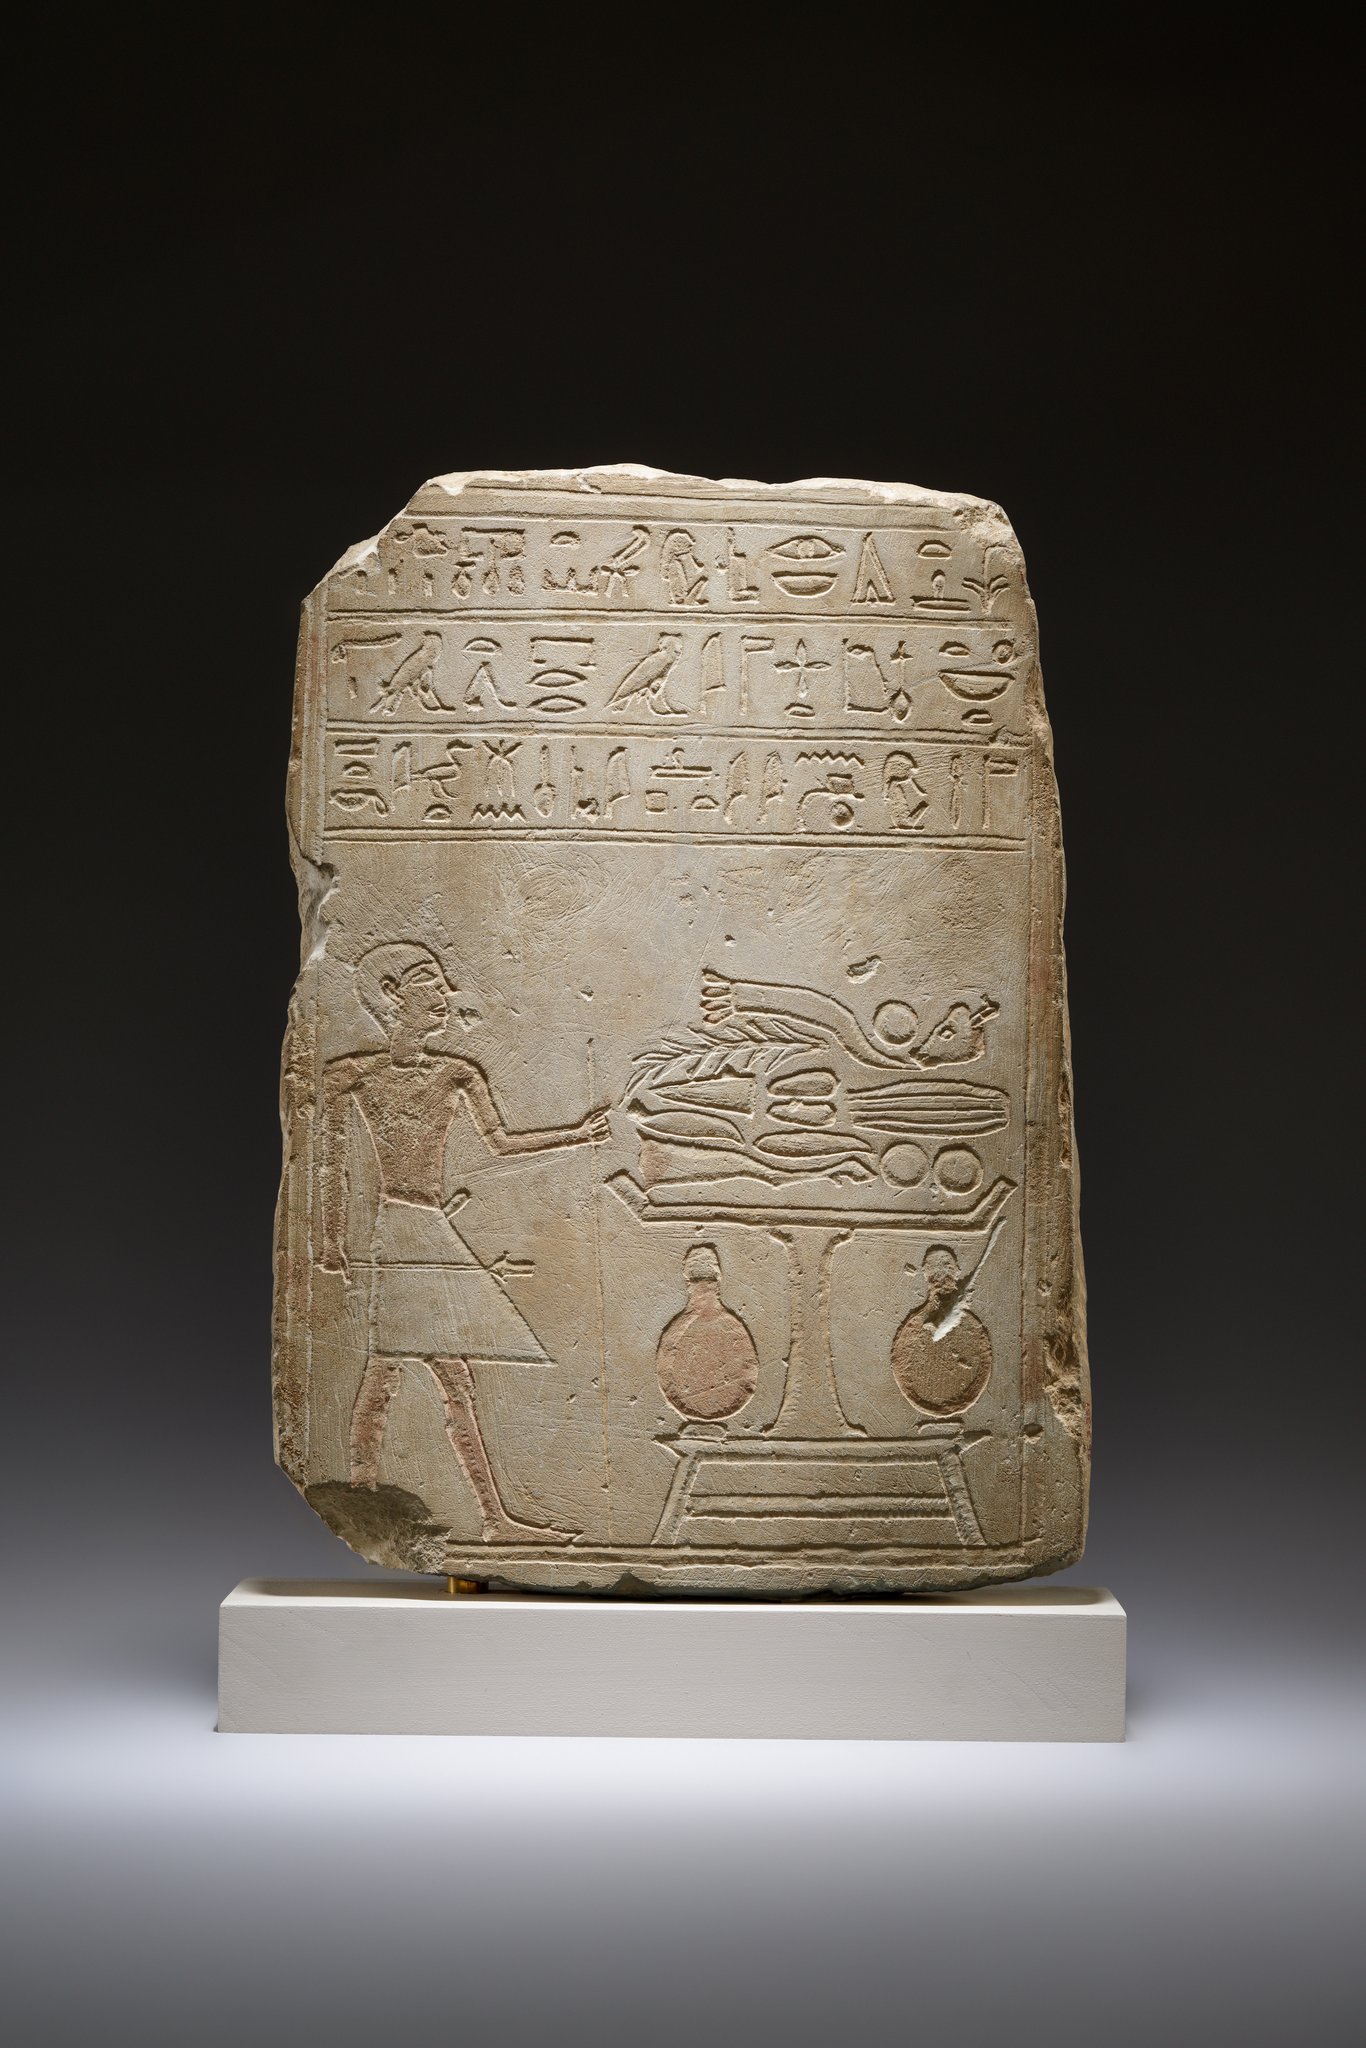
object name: stela, hetepi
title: Stela of Hetepi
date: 1981-1917 BCE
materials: limestone, paint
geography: egypt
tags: men,hieroglyphs